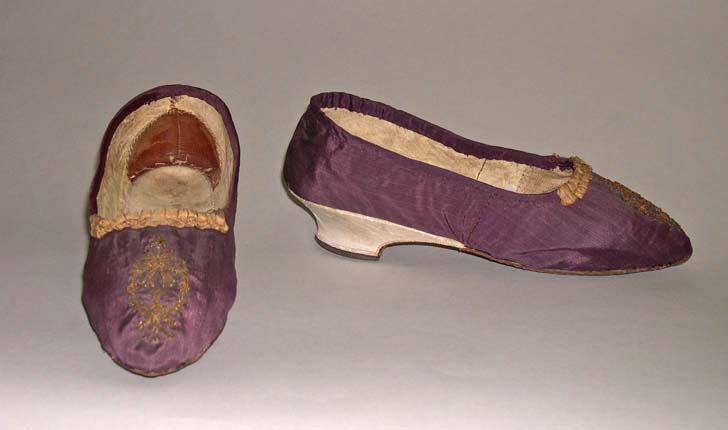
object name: pump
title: Pumps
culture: french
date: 1780-1789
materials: silk